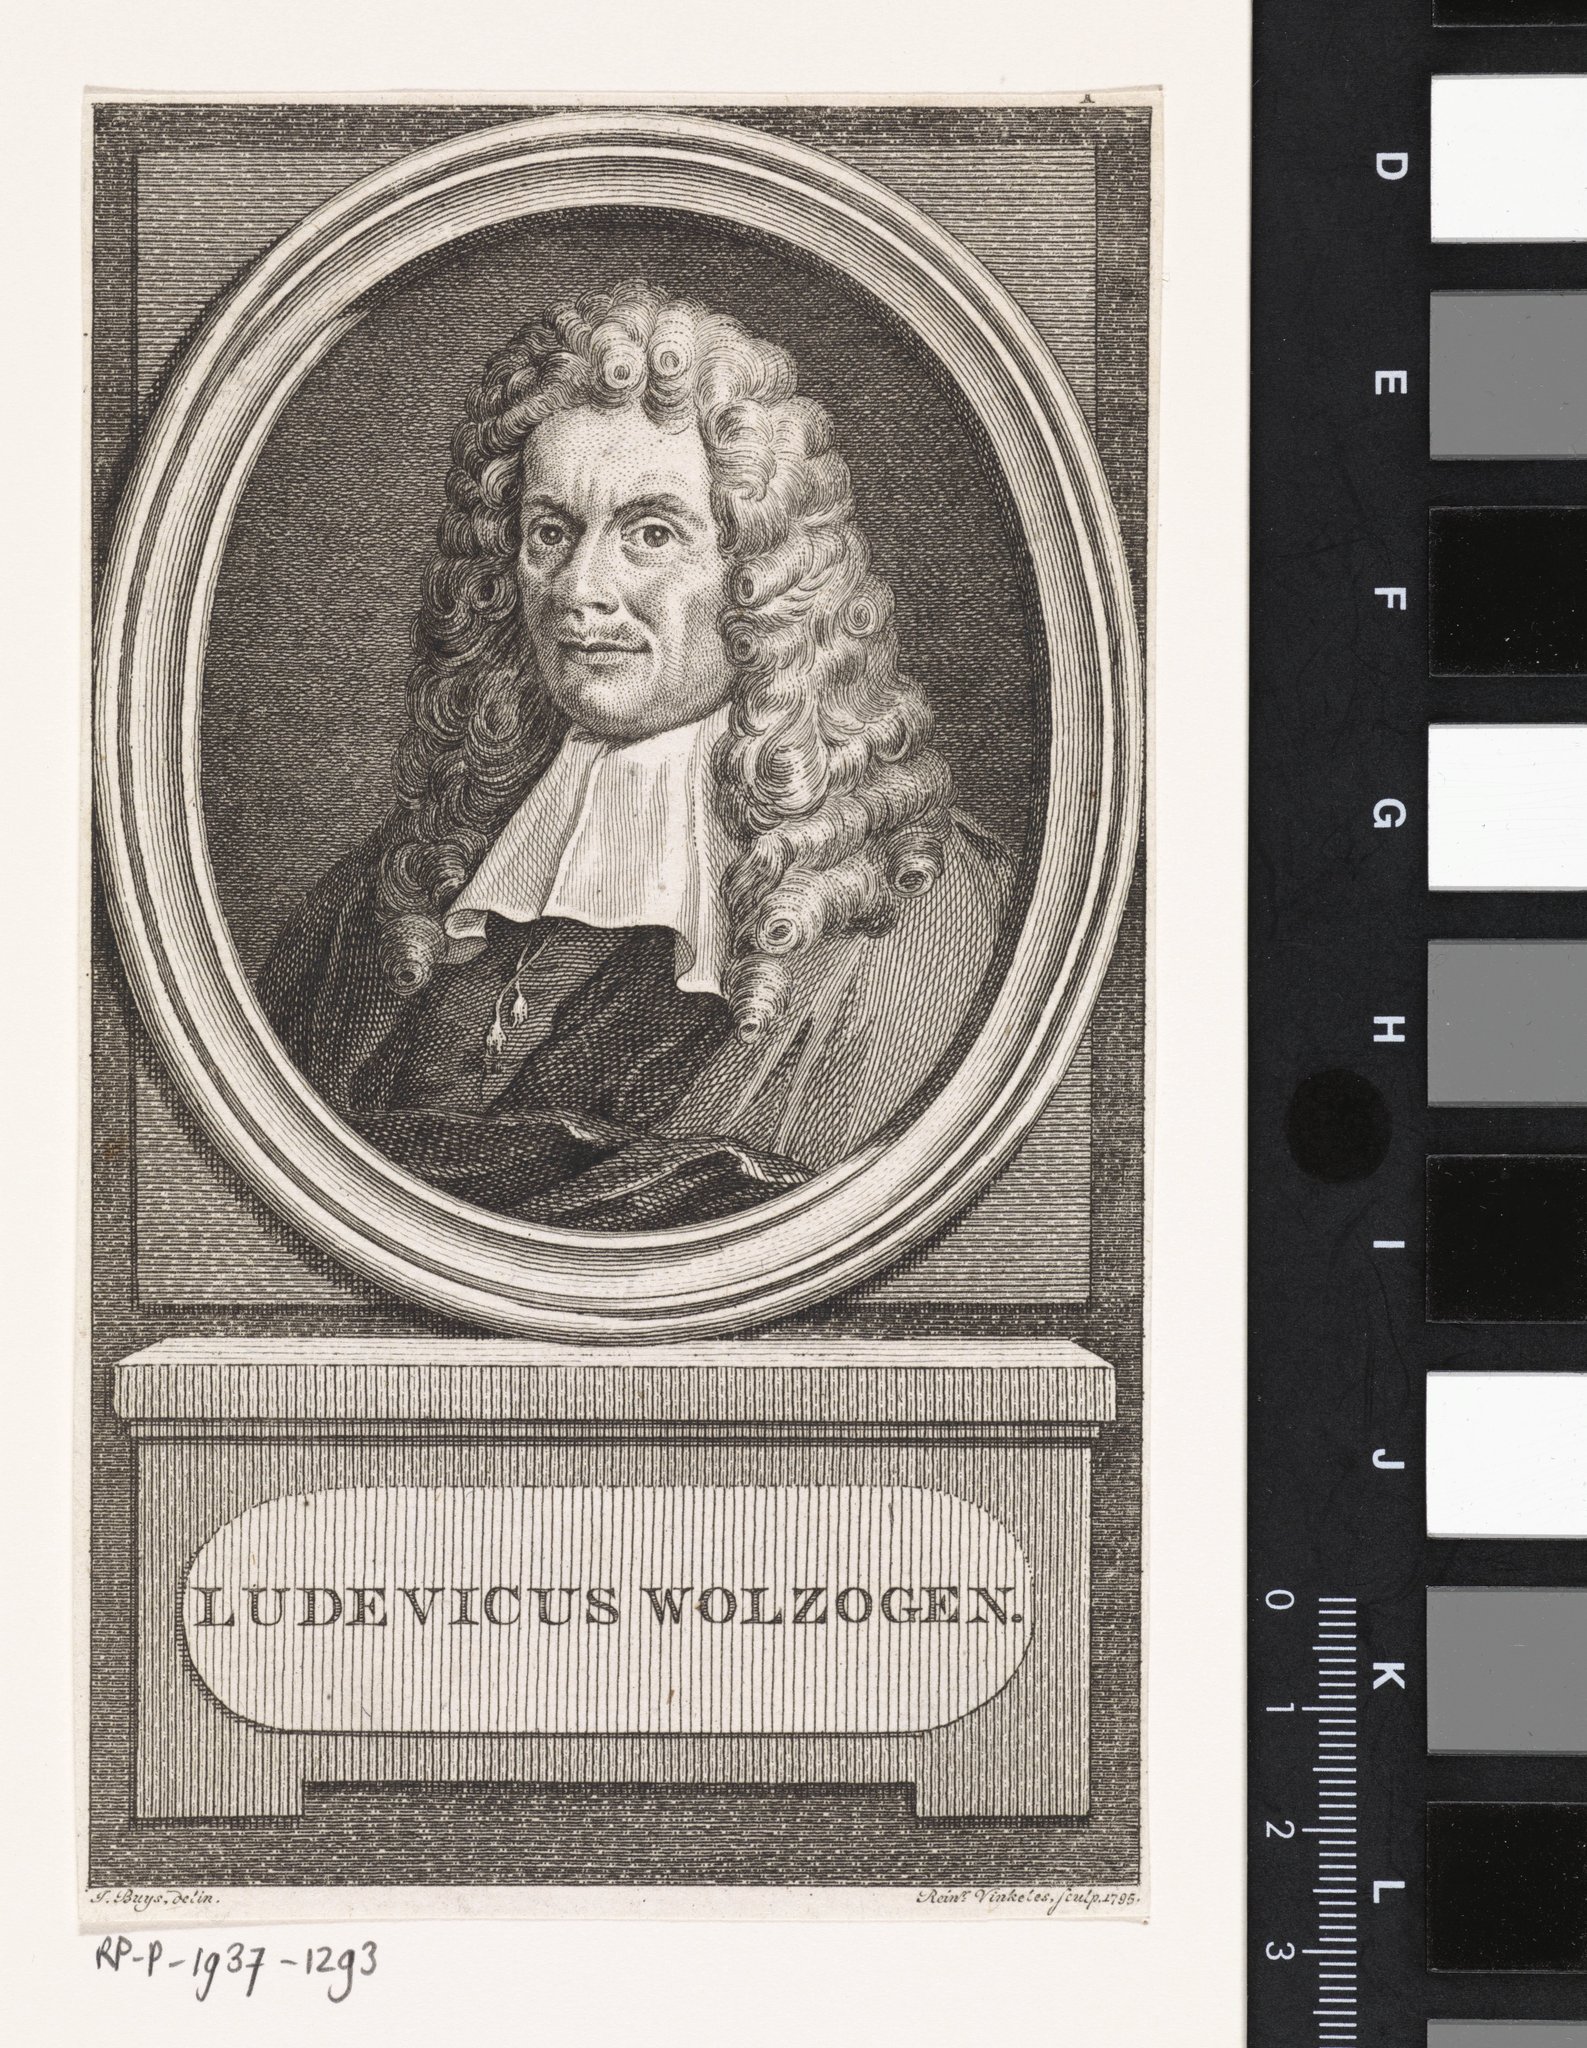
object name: print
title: Portret van Ludovicus Wolzogen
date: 1795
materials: paper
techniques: engraving, etching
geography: amsterdam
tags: amersfoort, theoloog, hoogleraar, ludovicus wolzogen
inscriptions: collector's mark: Lugt 2228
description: Prent gebruikt als boekillustratie in: Kok, Jacobus. Vaderlandsch woordenboek : met kaarten, plaaten en pourtraitten. Amsterdam: Johannes Allart, 1785-1796. Deel XXXIII.